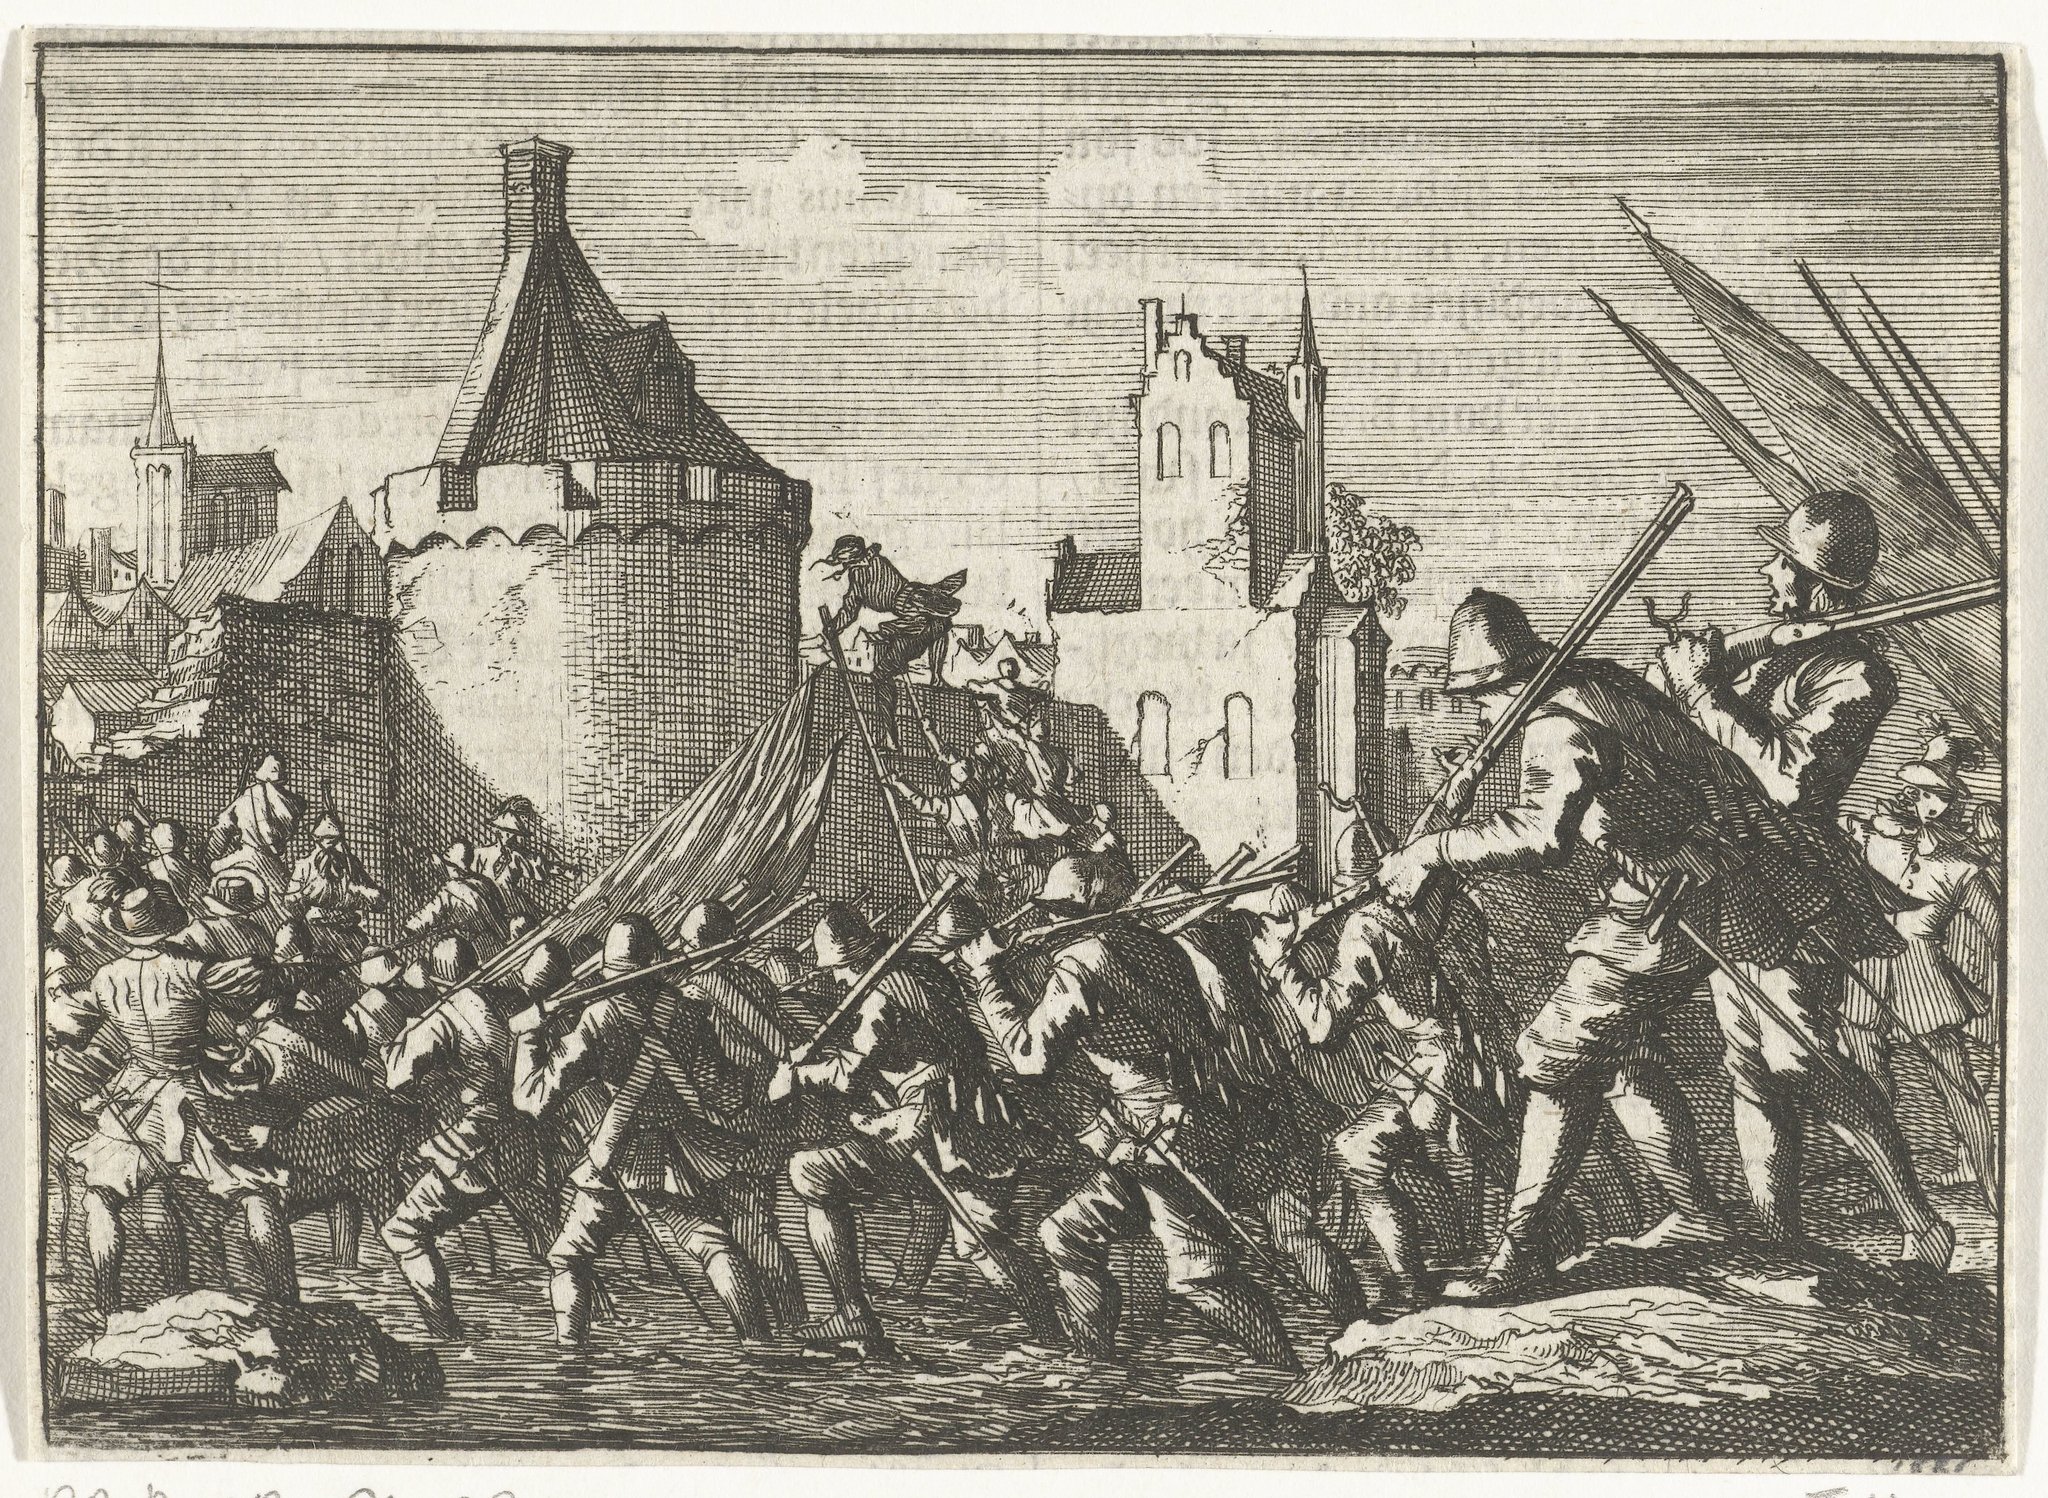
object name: print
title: Bestorming van Goch, 1625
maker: jan luyken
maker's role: draughtsman, print maker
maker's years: 1649-1712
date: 1696-1700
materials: paper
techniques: etching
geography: northern netherlands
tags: capture of city (after the siege)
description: Bestorming en verovering van Goch door de troepen van Lambert Charles, gouverneur van Nijmegen, tijdens het beleg van Breda toen Spinola troepen aan de bezetting van Goch had onttrokken. Bedrukt op achterzijde met tekst in het Nederlands.